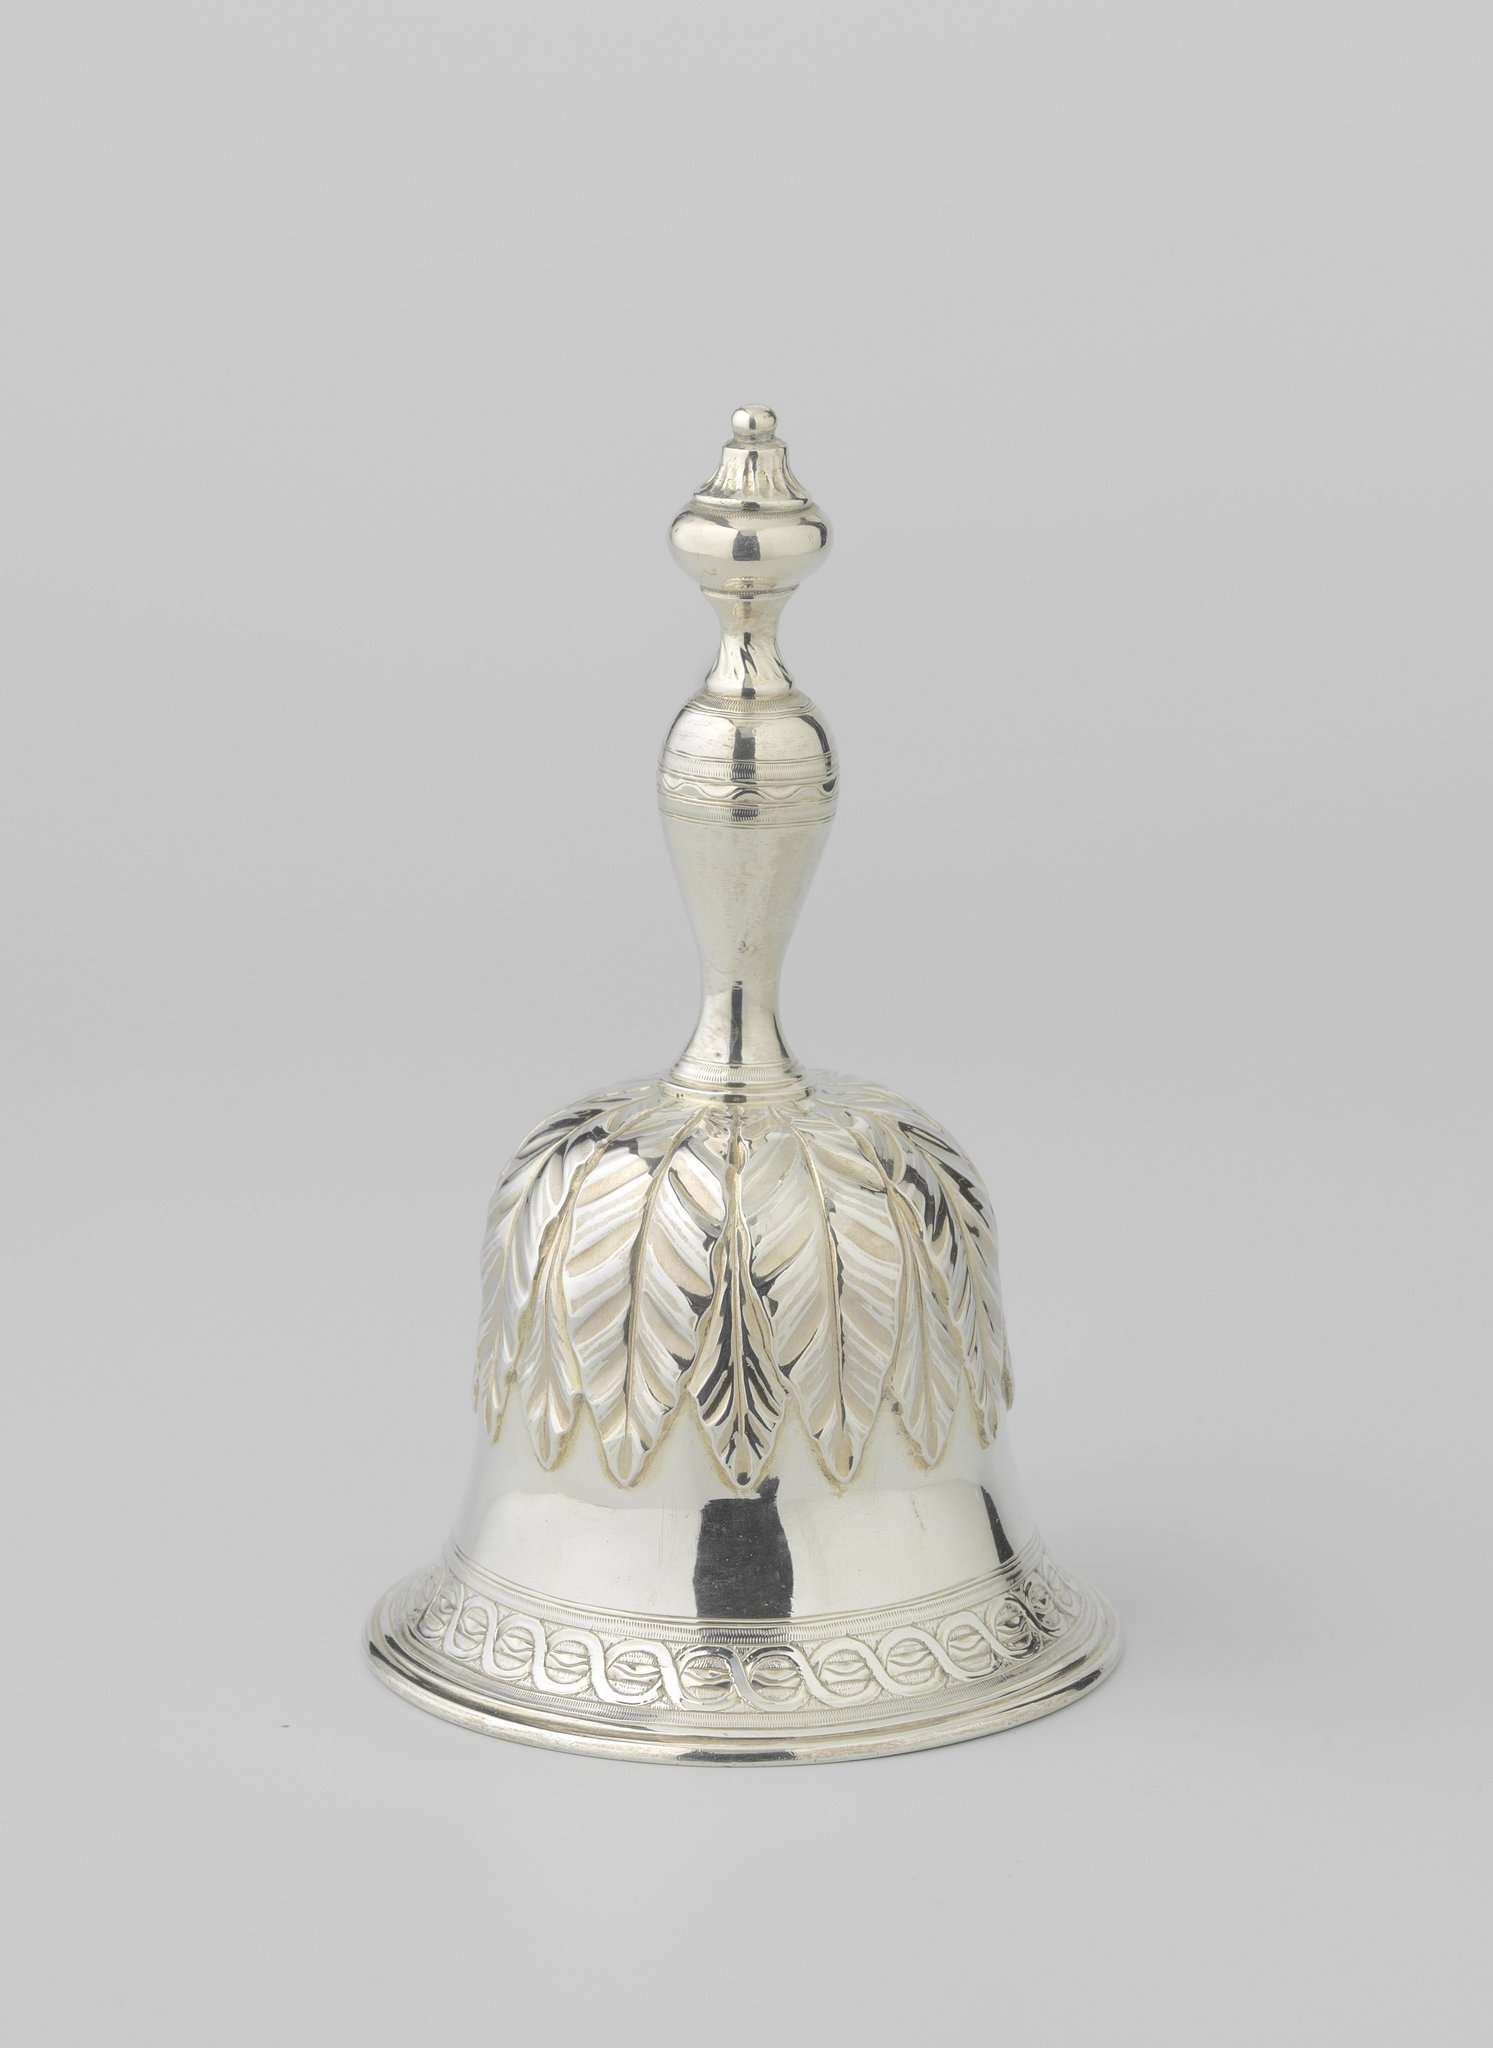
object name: handbell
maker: johannes schiotling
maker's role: silversmith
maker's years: 1730-1799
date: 1778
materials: silver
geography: amsterdam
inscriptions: hallmark, alloy mark, maker's mark, town mark, date letter: ‘T’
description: De klokvormige bel heeft een balustervormige steel met een bolvormige knop. Langs de onderzijde van de bel loopt een glad profiel met daarboven een gegraveerde rand van twee geslingerde linten voor een band met een slingerlijn tegen een in glanssteek gearceerde achtergrond. Deze rand wordt geflankeerd door smallere banden met soortgelijke arceringen. Het bovenste deel van de bel is gedreven met twee lagen straalsgewijs op elkaar gelegde acanthusbladeren. Langs onder- en bovenzijde van de gegoten steel zijn randen in glanssteek aangebracht; over het breedste gedeelte lopen er twee, een band met een slingerlijn flankerend. Steel en knop worden gescheiden door een ingesnoerde verbinding waarvan het onderste deel gedraaide cannelures vertoont. De bolvormige knop is langs boven- en onderzijde versierd met een zigzaglijntje en wordt bekroond door een gewelfd, zich verjongend, gecanneleerd voetstukje met een bolletje.